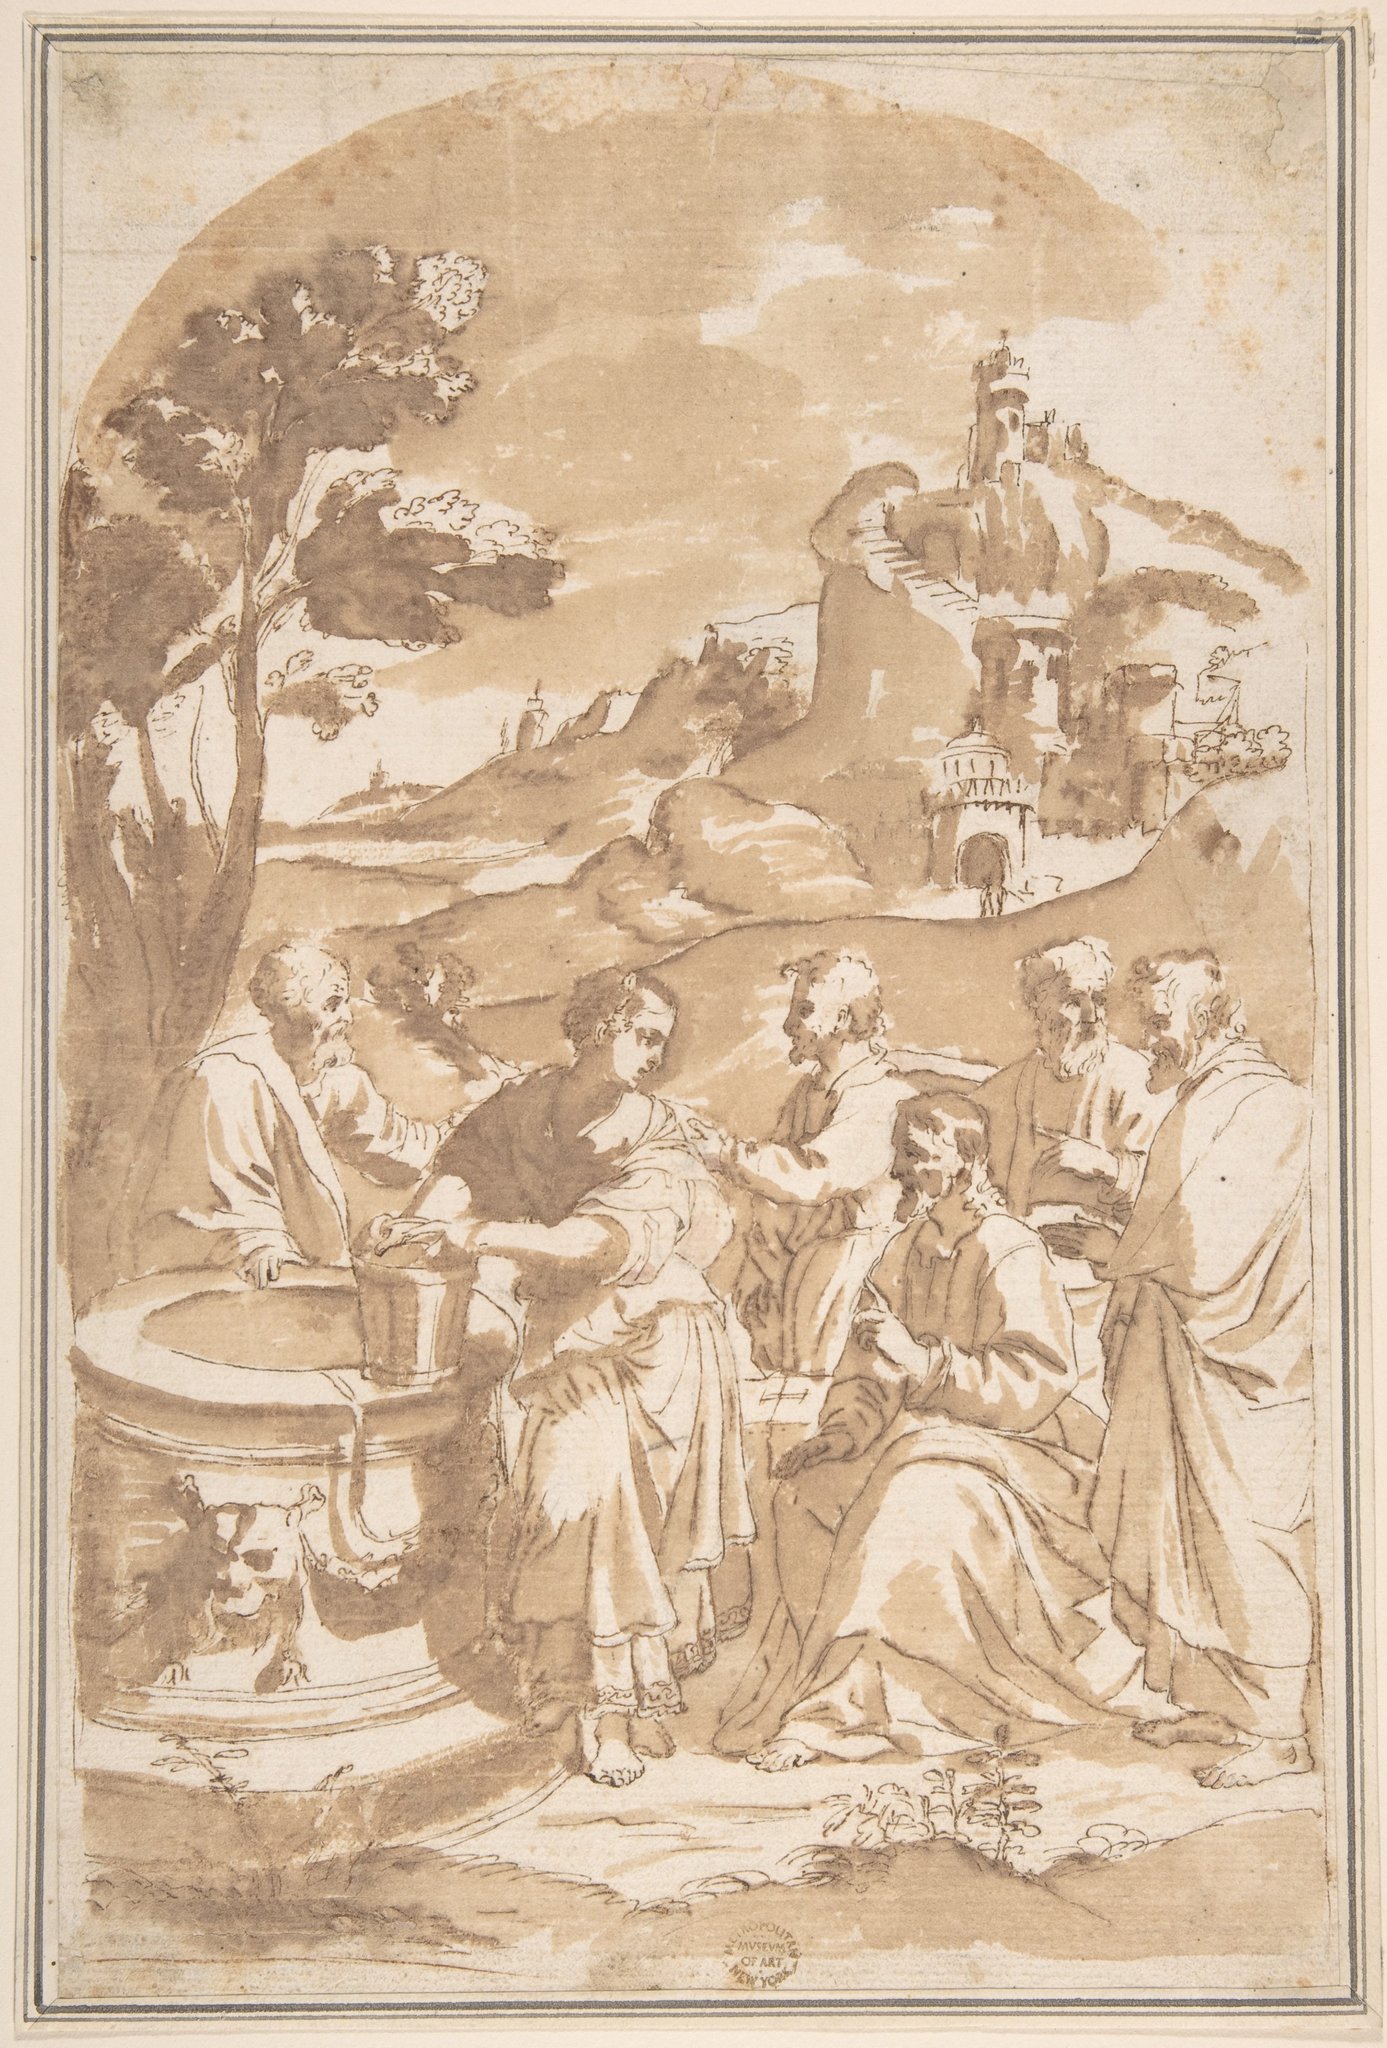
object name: drawing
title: Christ and the Woman of Samaria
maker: anonymous, italian, 16th century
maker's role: artist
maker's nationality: italian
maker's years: 1550-1600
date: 1501-1600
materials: ink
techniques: brush, pen, wash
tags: wells,men,women,trees,christ